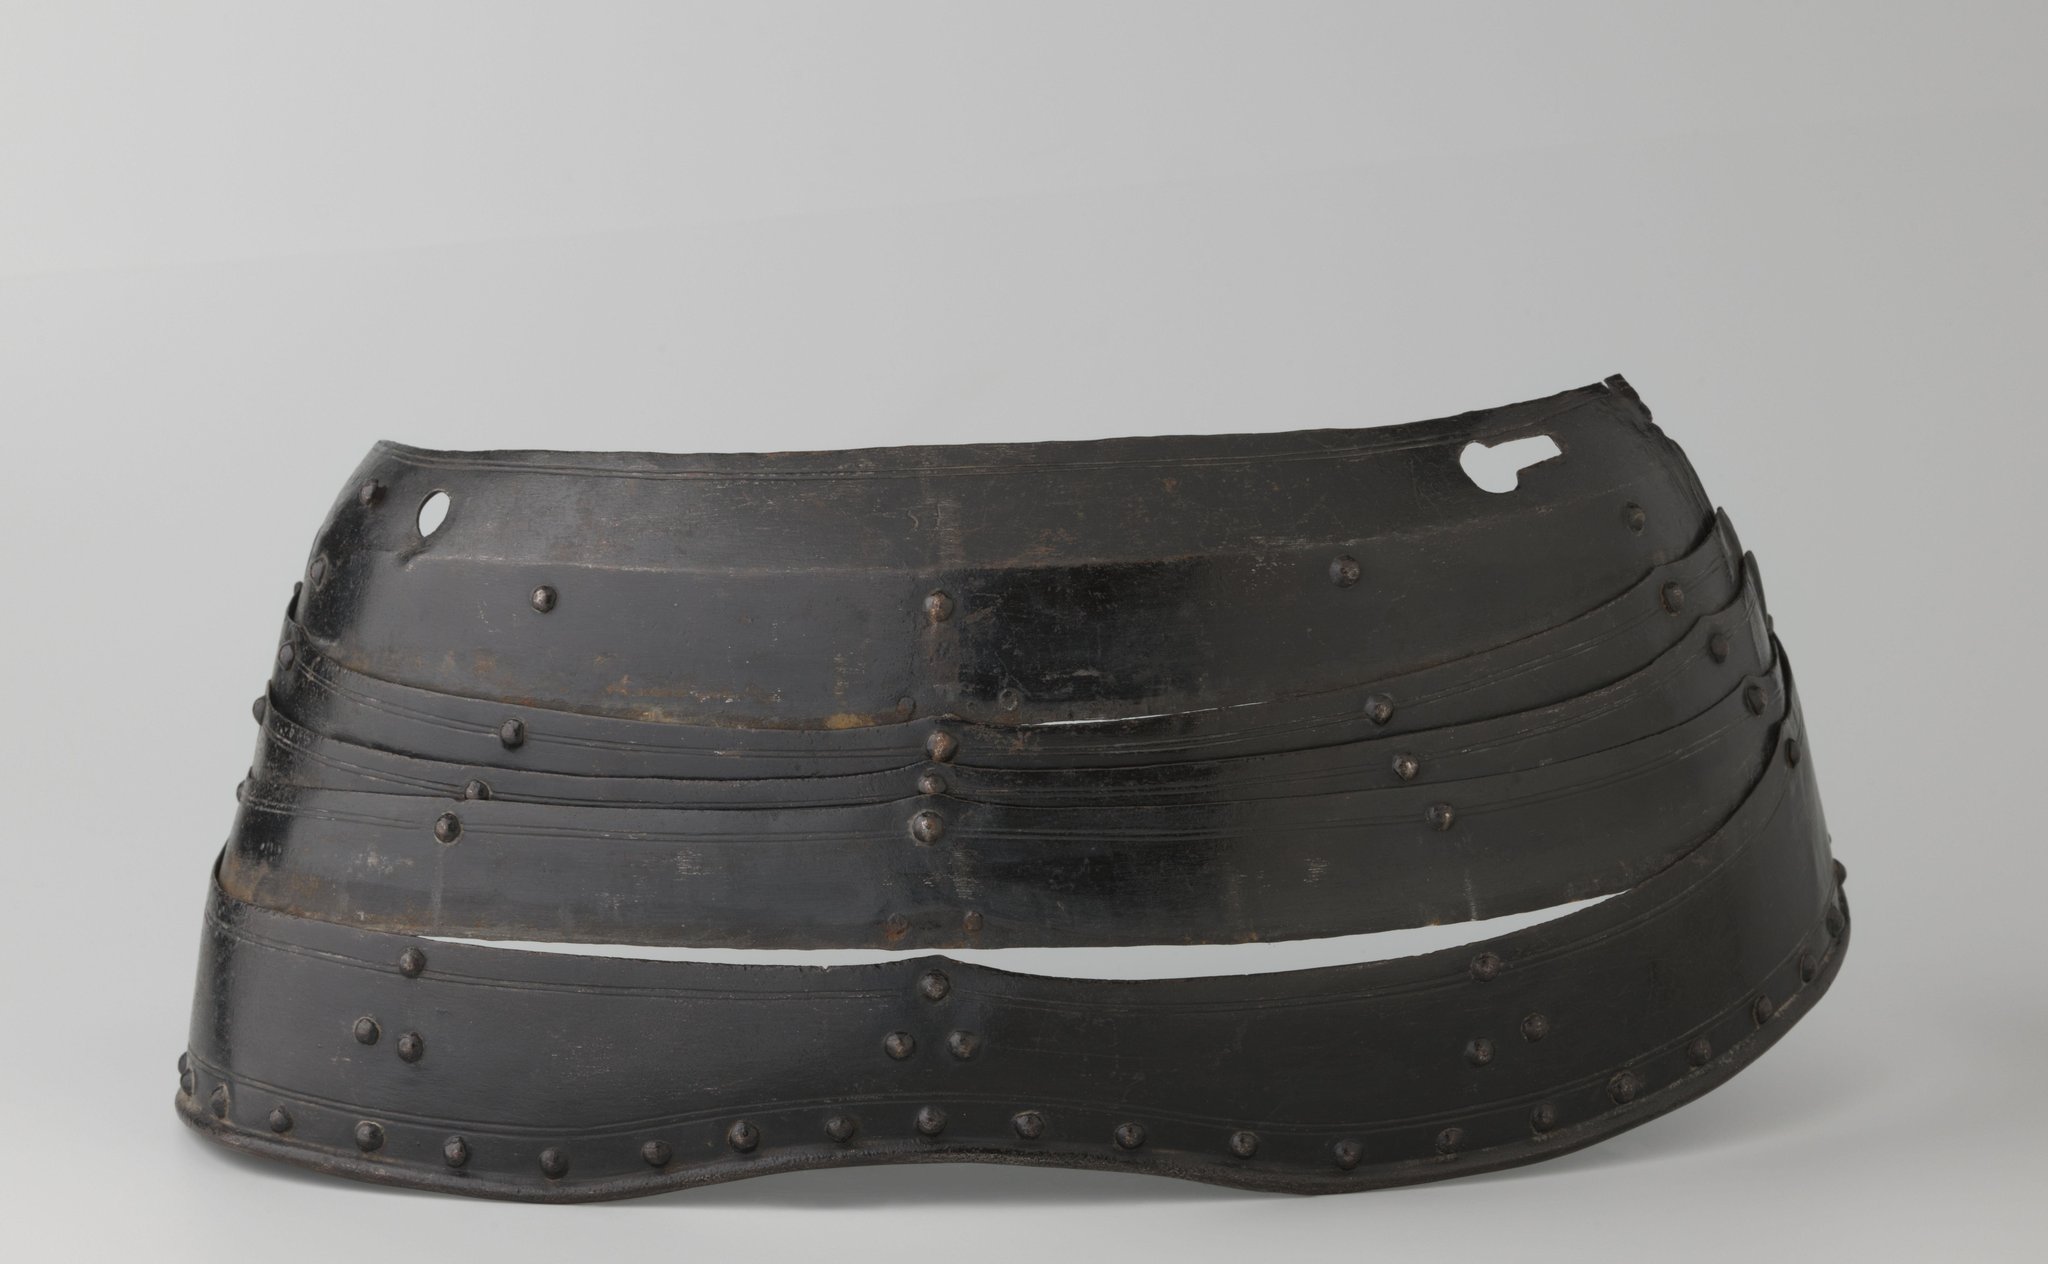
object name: rugstuk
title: Lendenstrook van kuras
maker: Anonymous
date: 1599-1699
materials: iron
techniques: forging, striking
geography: europe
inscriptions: : ‘XXX’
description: Lendenstrook van kuras, ijzer, zwart, behoort onder de rugplaat van een kuras en bestaat uit gearticuleerde stroken die aan weerzijden over elkaar zijn geklonken met klinknagels, In de bovenste strook twee gaten waaraan de lendenstrook aan de rugplaat bevestigd kan worden. De randen zijn omgelfenst. De binnenzijde is zwart en op de onderste strook is het stadsmerk van de stad Amsterdam geschreven.